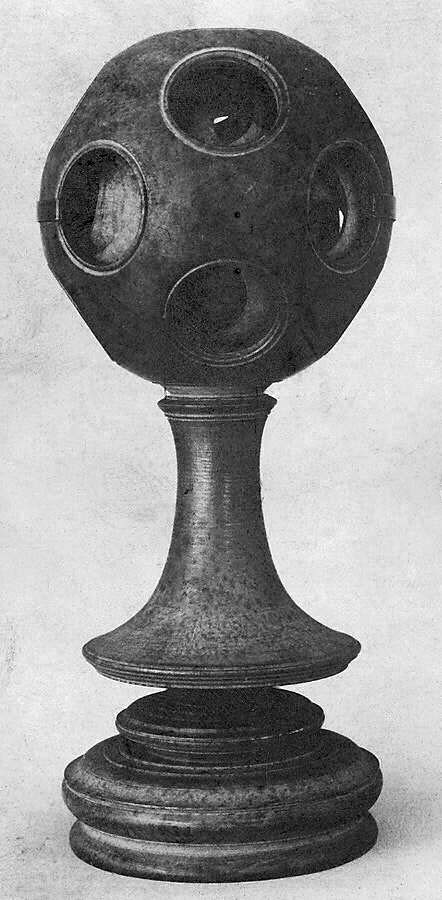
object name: sphere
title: Nest of Spheres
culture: chinese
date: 1801-1900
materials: wood